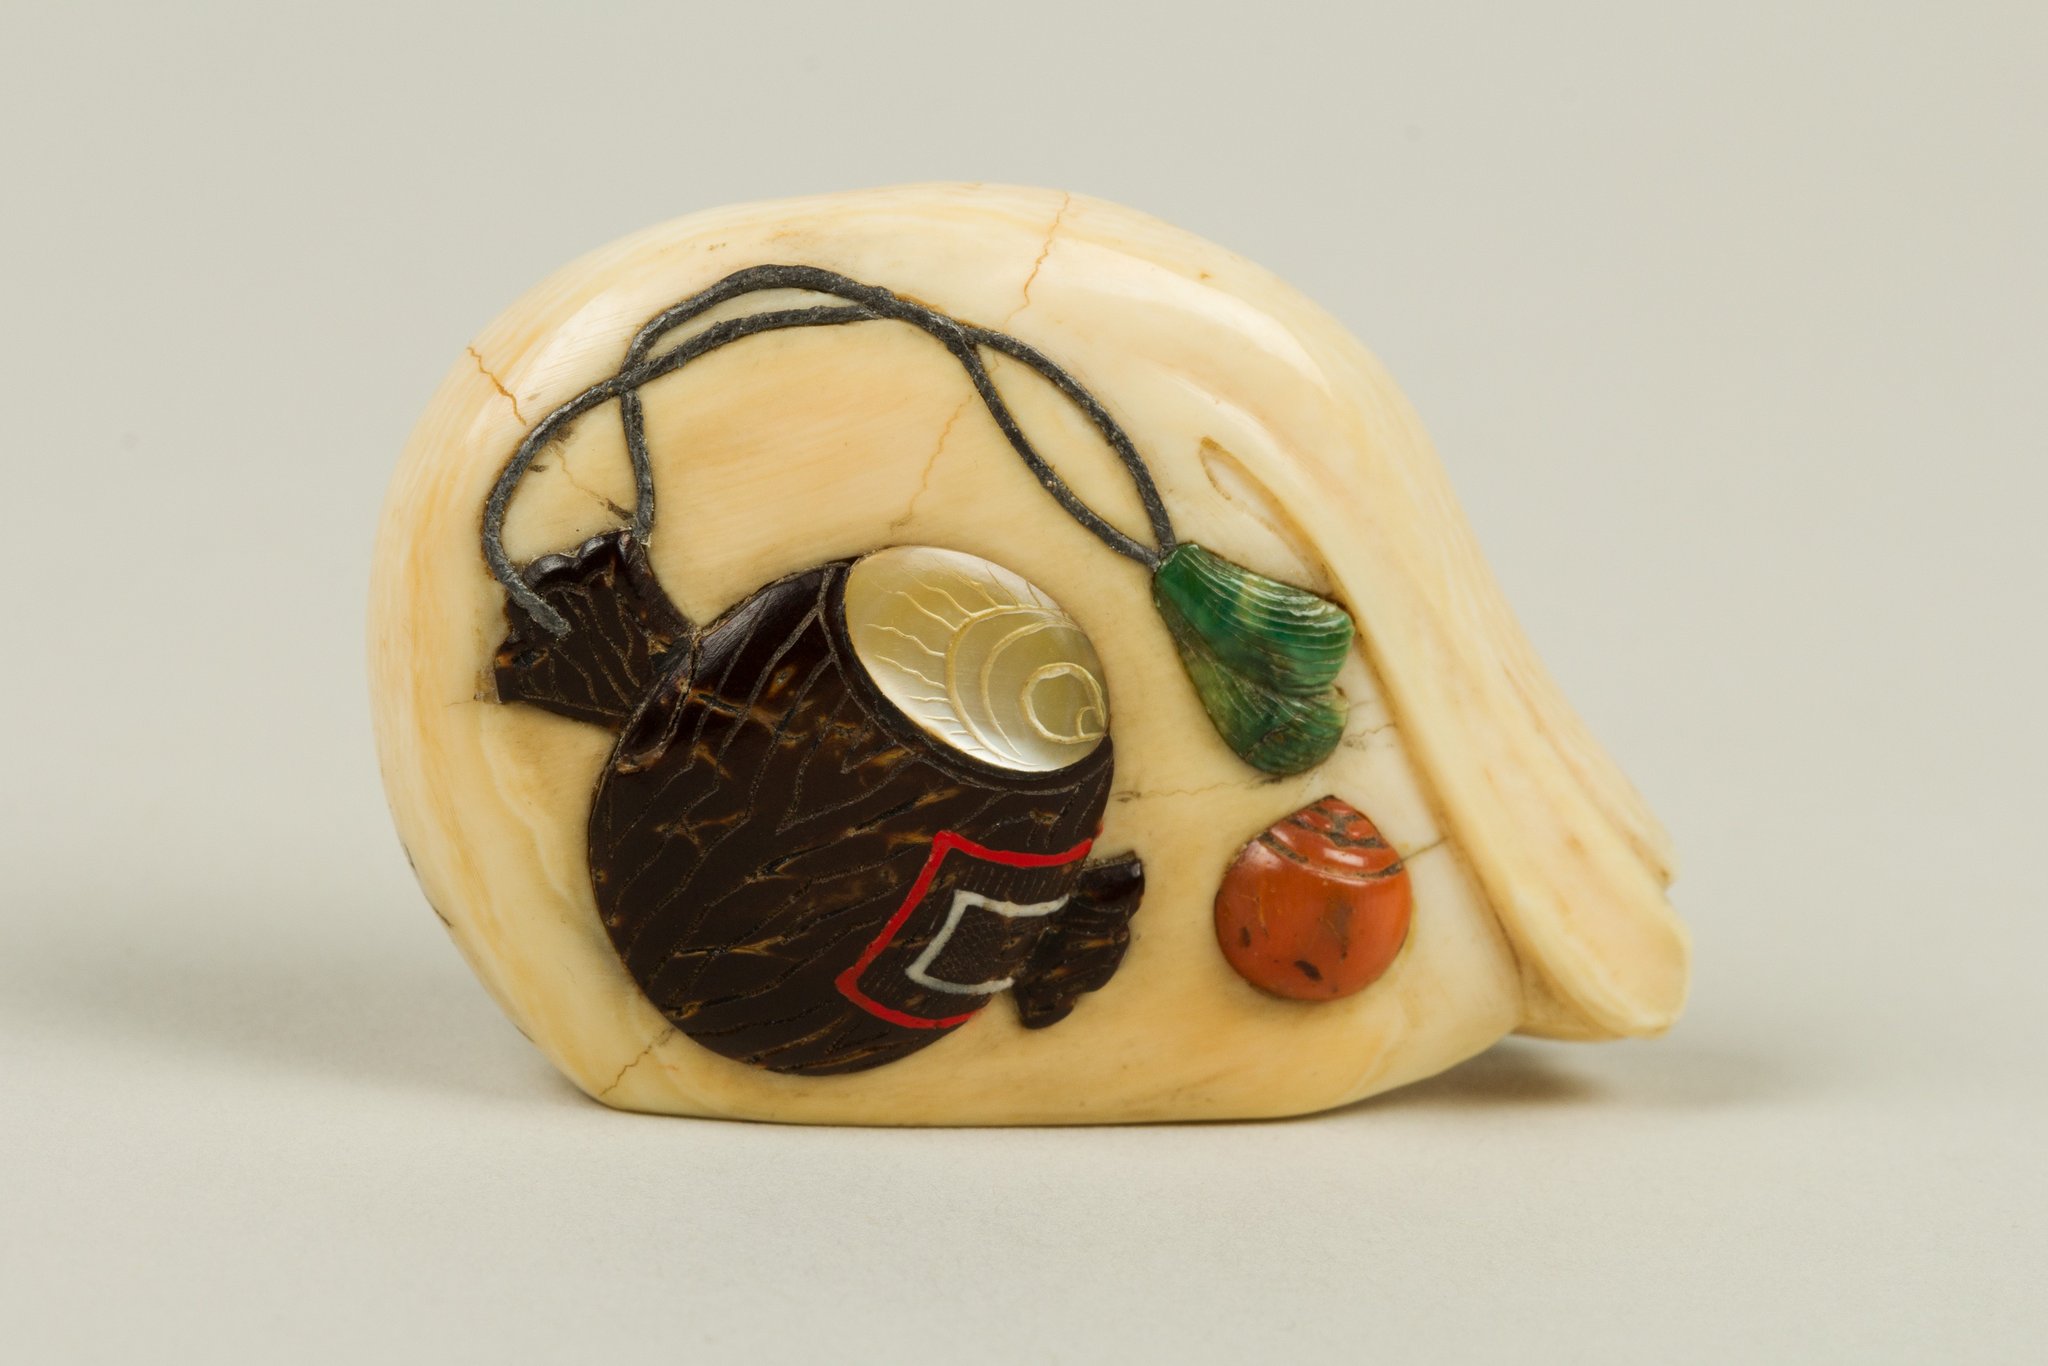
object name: netsuke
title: Netsuke of Daikoku with Mallet and Bag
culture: japanese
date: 1801-1900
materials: ivory, stone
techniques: inlay